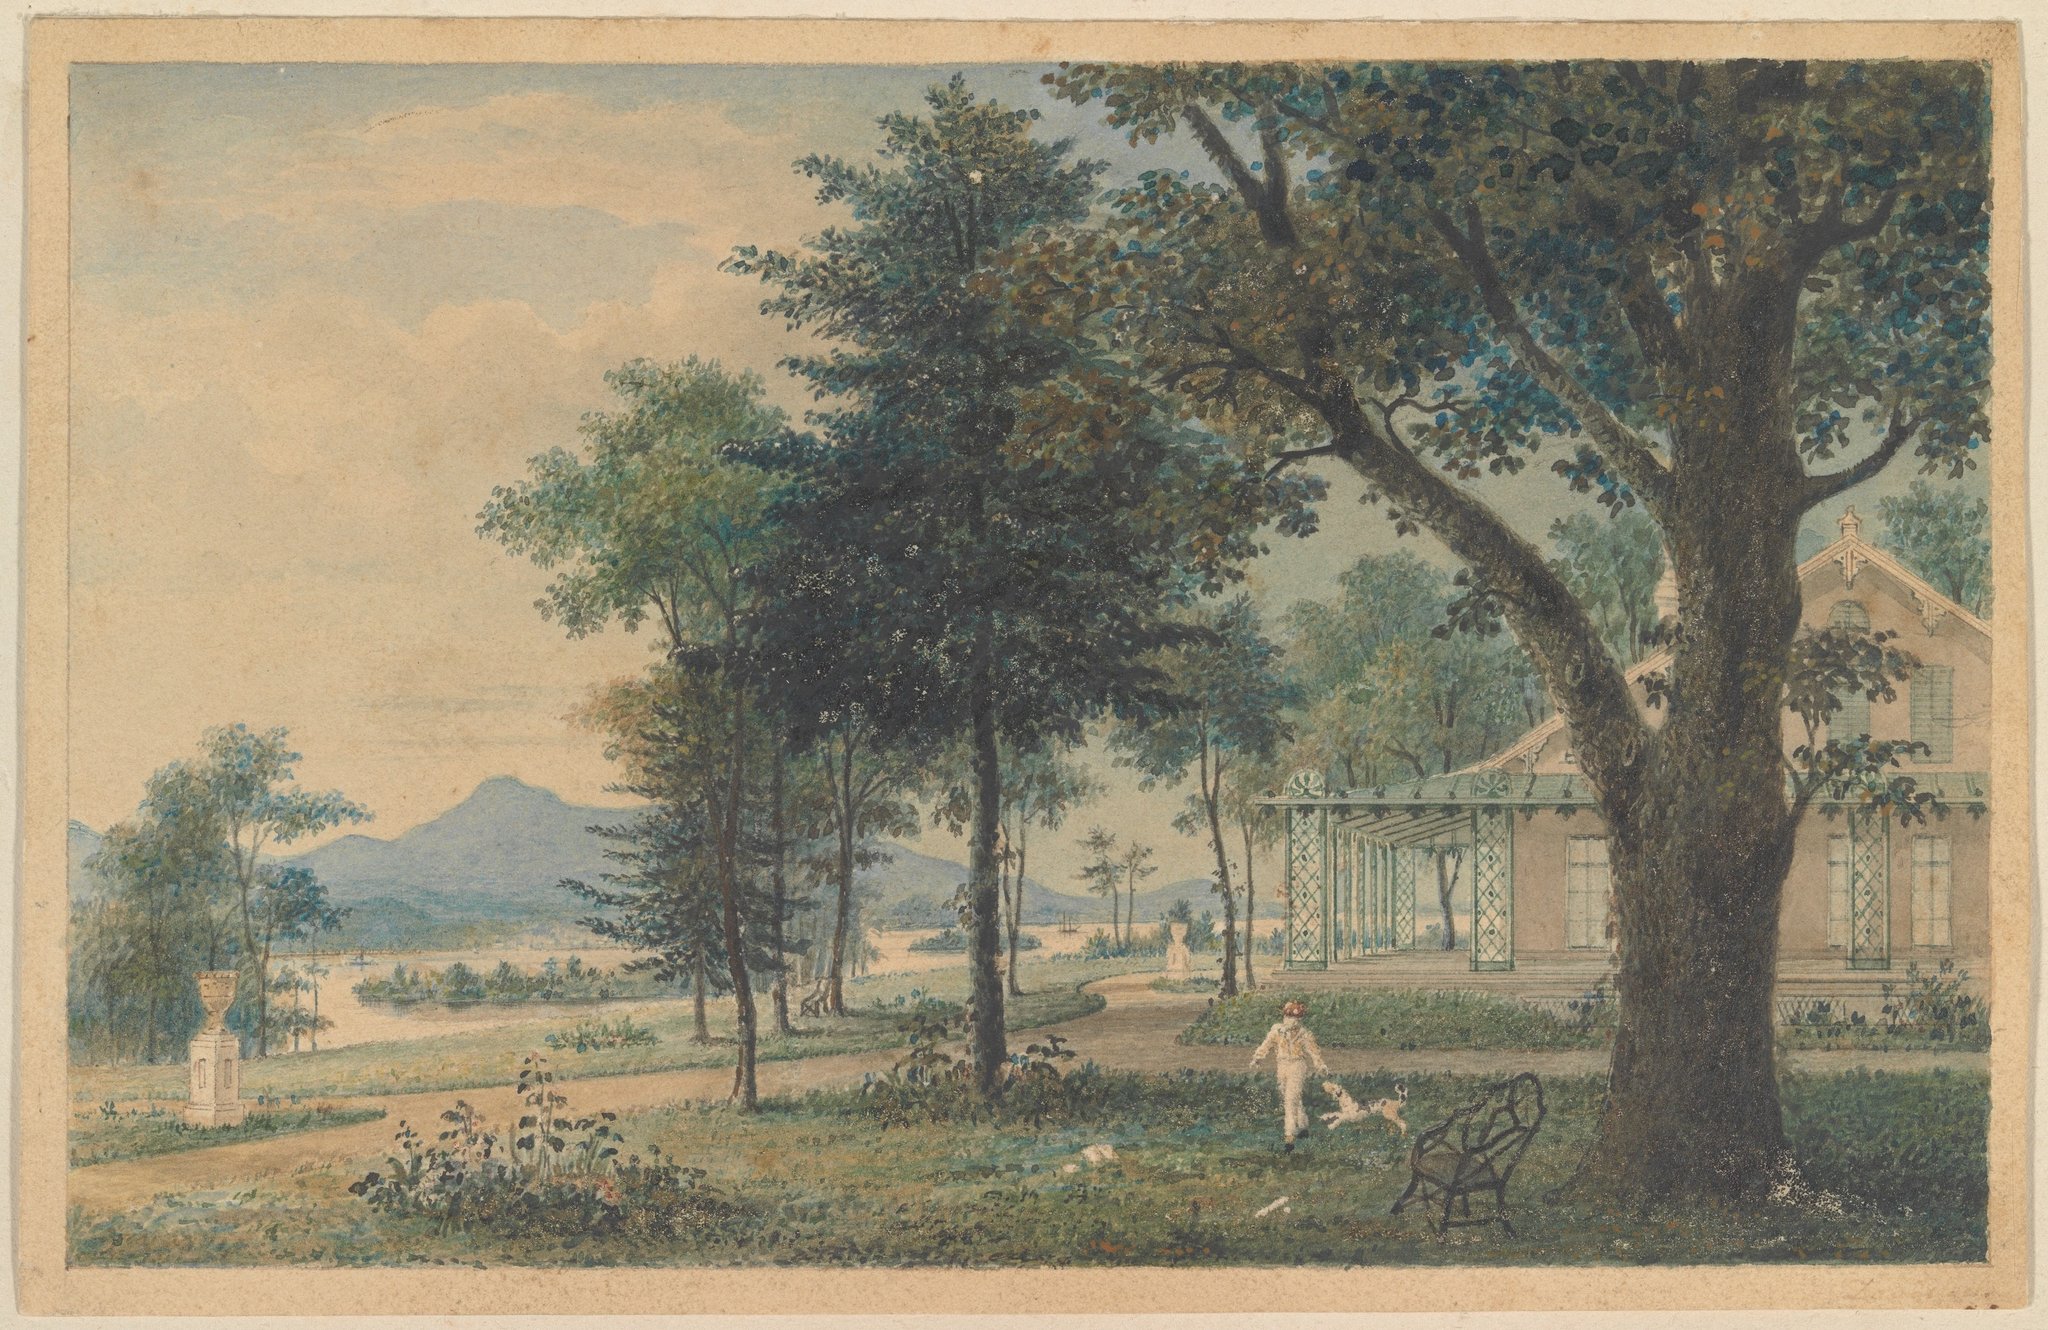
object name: book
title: A Treatise on the Theory and Practice of Landscape Gardening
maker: andrew jackson downing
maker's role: author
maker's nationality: american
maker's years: 1815-1852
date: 1841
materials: watercolor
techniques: engraving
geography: boston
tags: buildings,gardens,boys,dogs,lakes,landscapes,trees